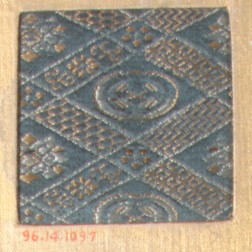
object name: piece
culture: japanese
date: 1701-1900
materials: silk